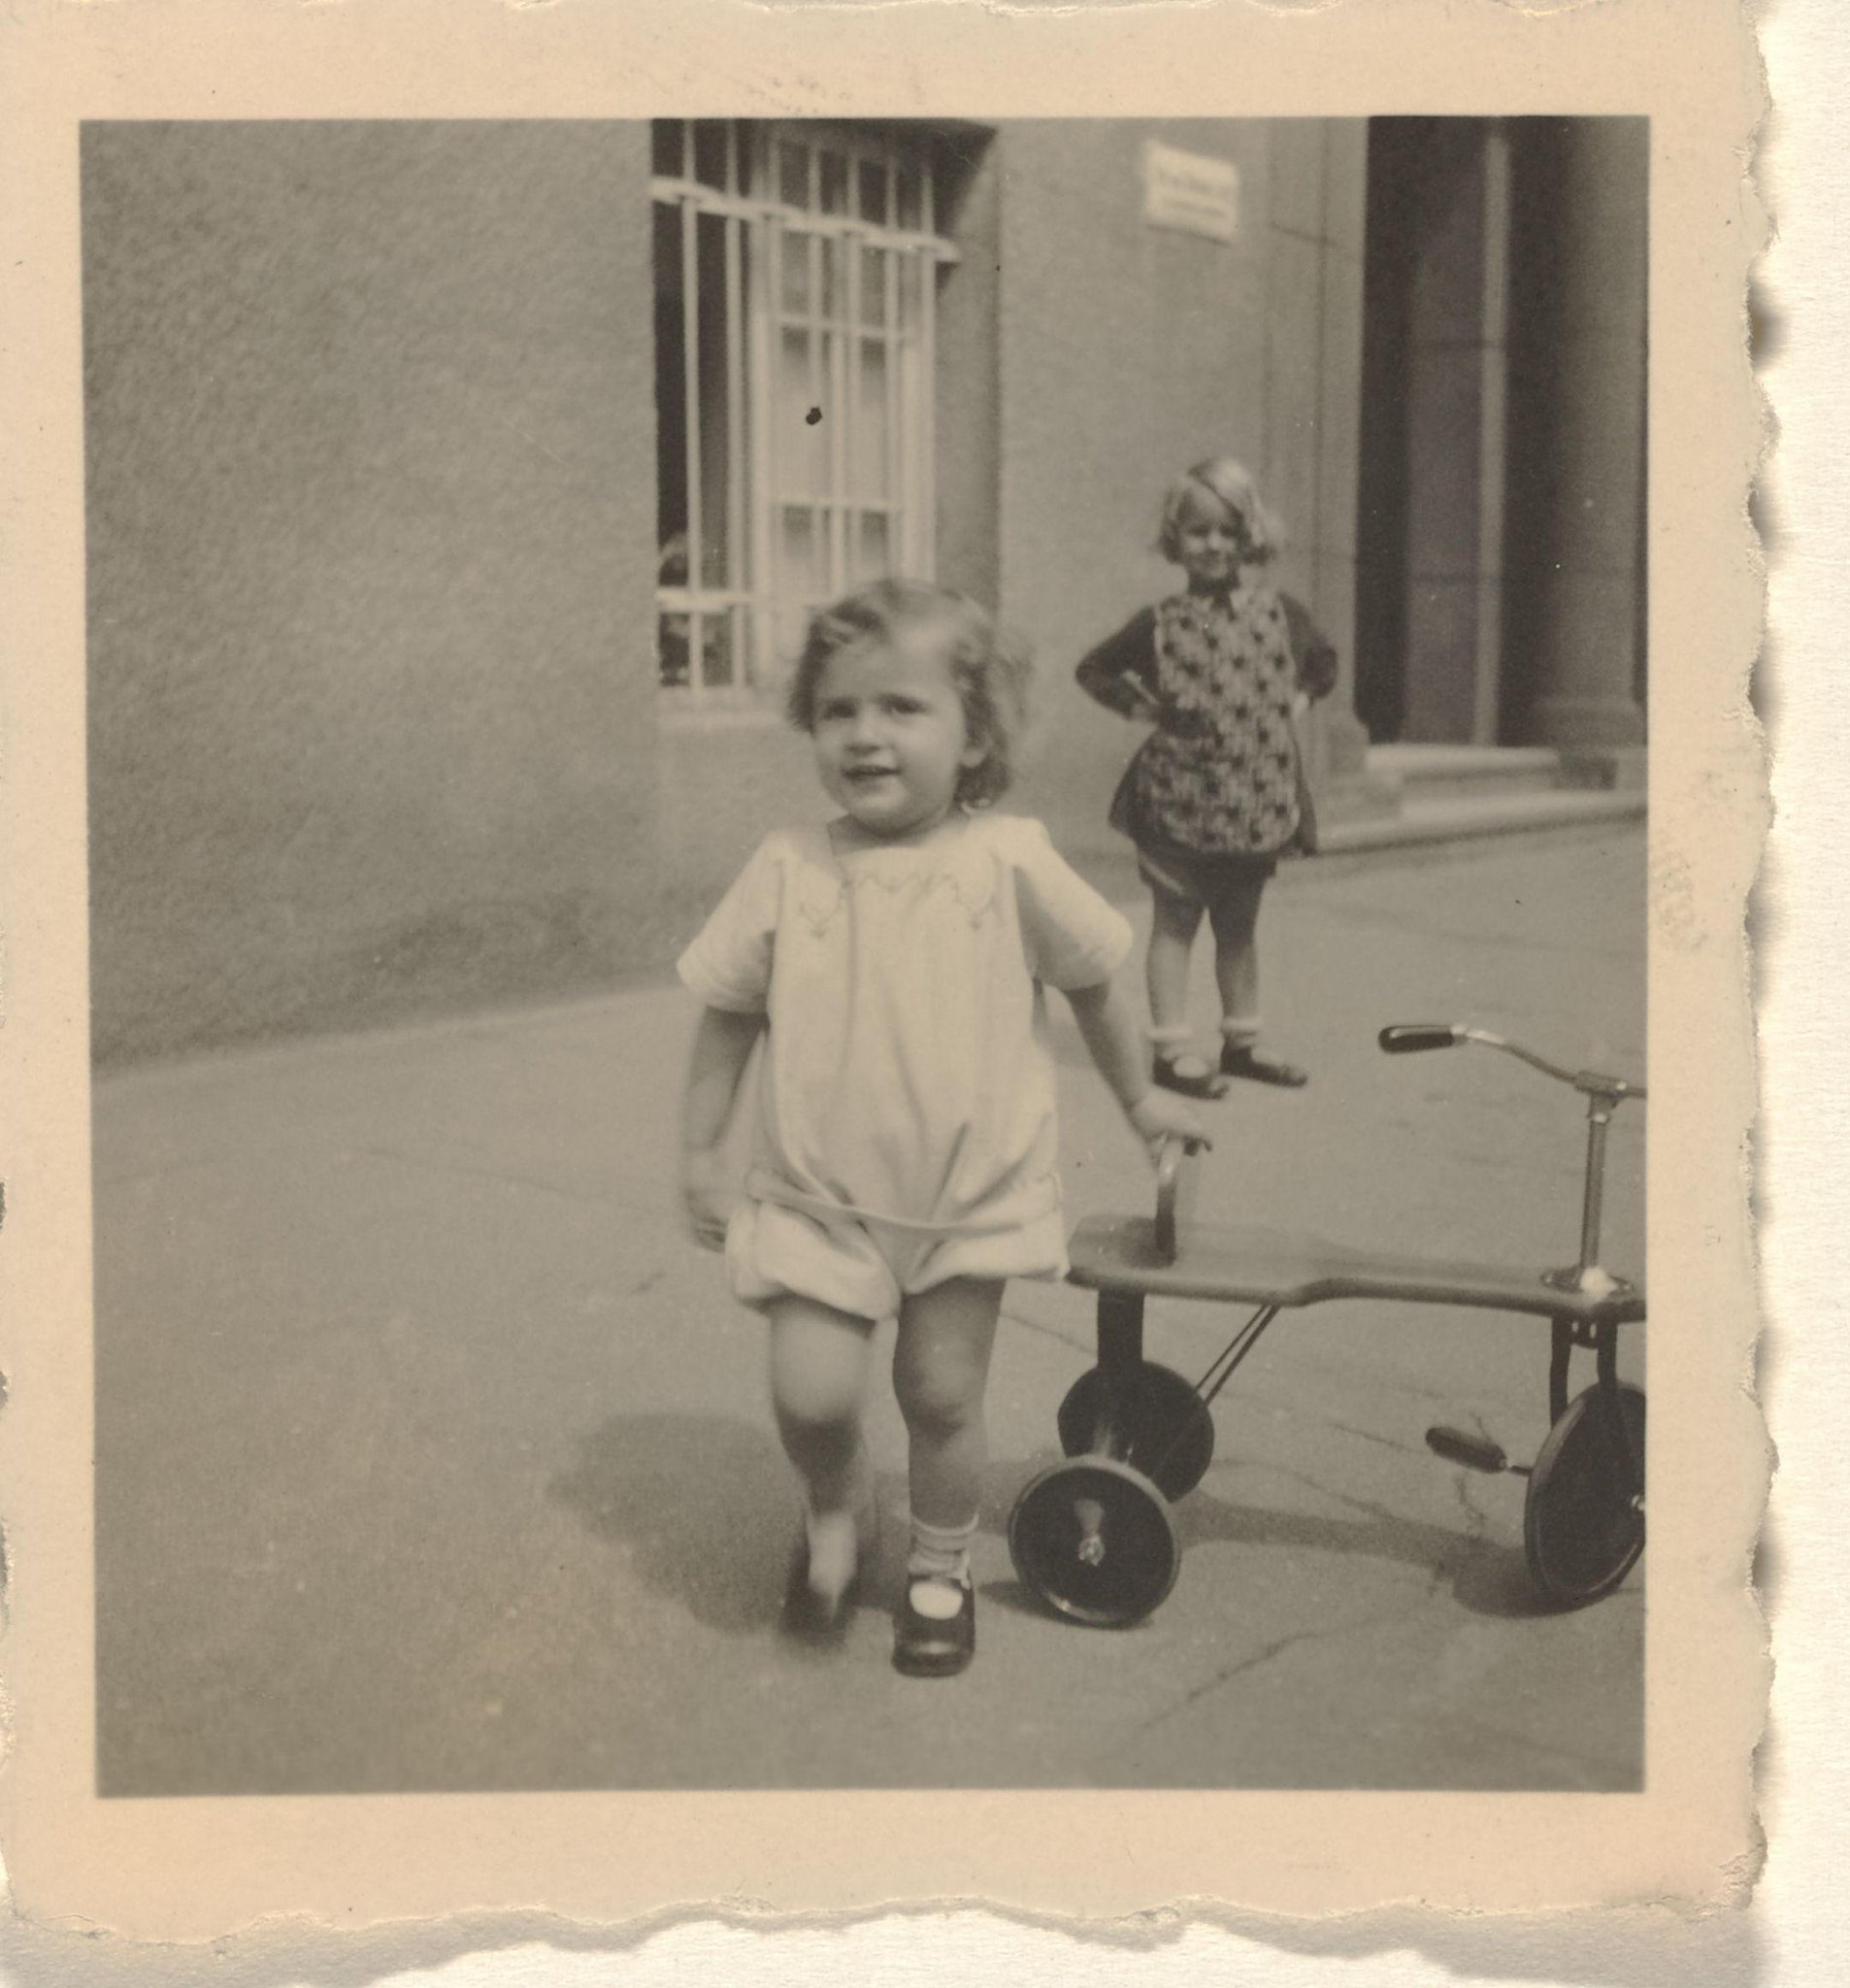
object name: photograph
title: Isabel Wachenheimer in München, mei 1929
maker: Anonymous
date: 1905-1929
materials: photographic support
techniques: gelatin silver print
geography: munich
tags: leiden, isabel wachenheimer-elon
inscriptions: date: ‘mitte mai München’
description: Dit object is onderdeel van de nalatenschap van Isabel Elon-Wachenheimer (1928-2010). Tot haar overlijden behoorde het samen met de andere objecten uit de nalatenschap tot haar privédomein van Isabel Wachenheimer. In die particuliere context zijn deze objecten tezamen en individueel aandenkens - aan de jeugd, ouders en familie van Isabel Wachenheimer vóór en tijdens de Shoah en aan haar leven na de Tweede Wereldoorlog. Isabel Wachenheimer, die van juni 1943 tot mei 1945 gevangen zat in Kamp Westerbork, Theresienstadt, Auschwitz, Lenzing a/d Oberdonau (een buitenkamp van Mauthausen), overleefde de Shoah. Haar ouders – Eugène Wachenheimer en Else Wachenheimer-Moos - werden op 14 oktober 1944 in Auschwitz-Birkenau vermoord.